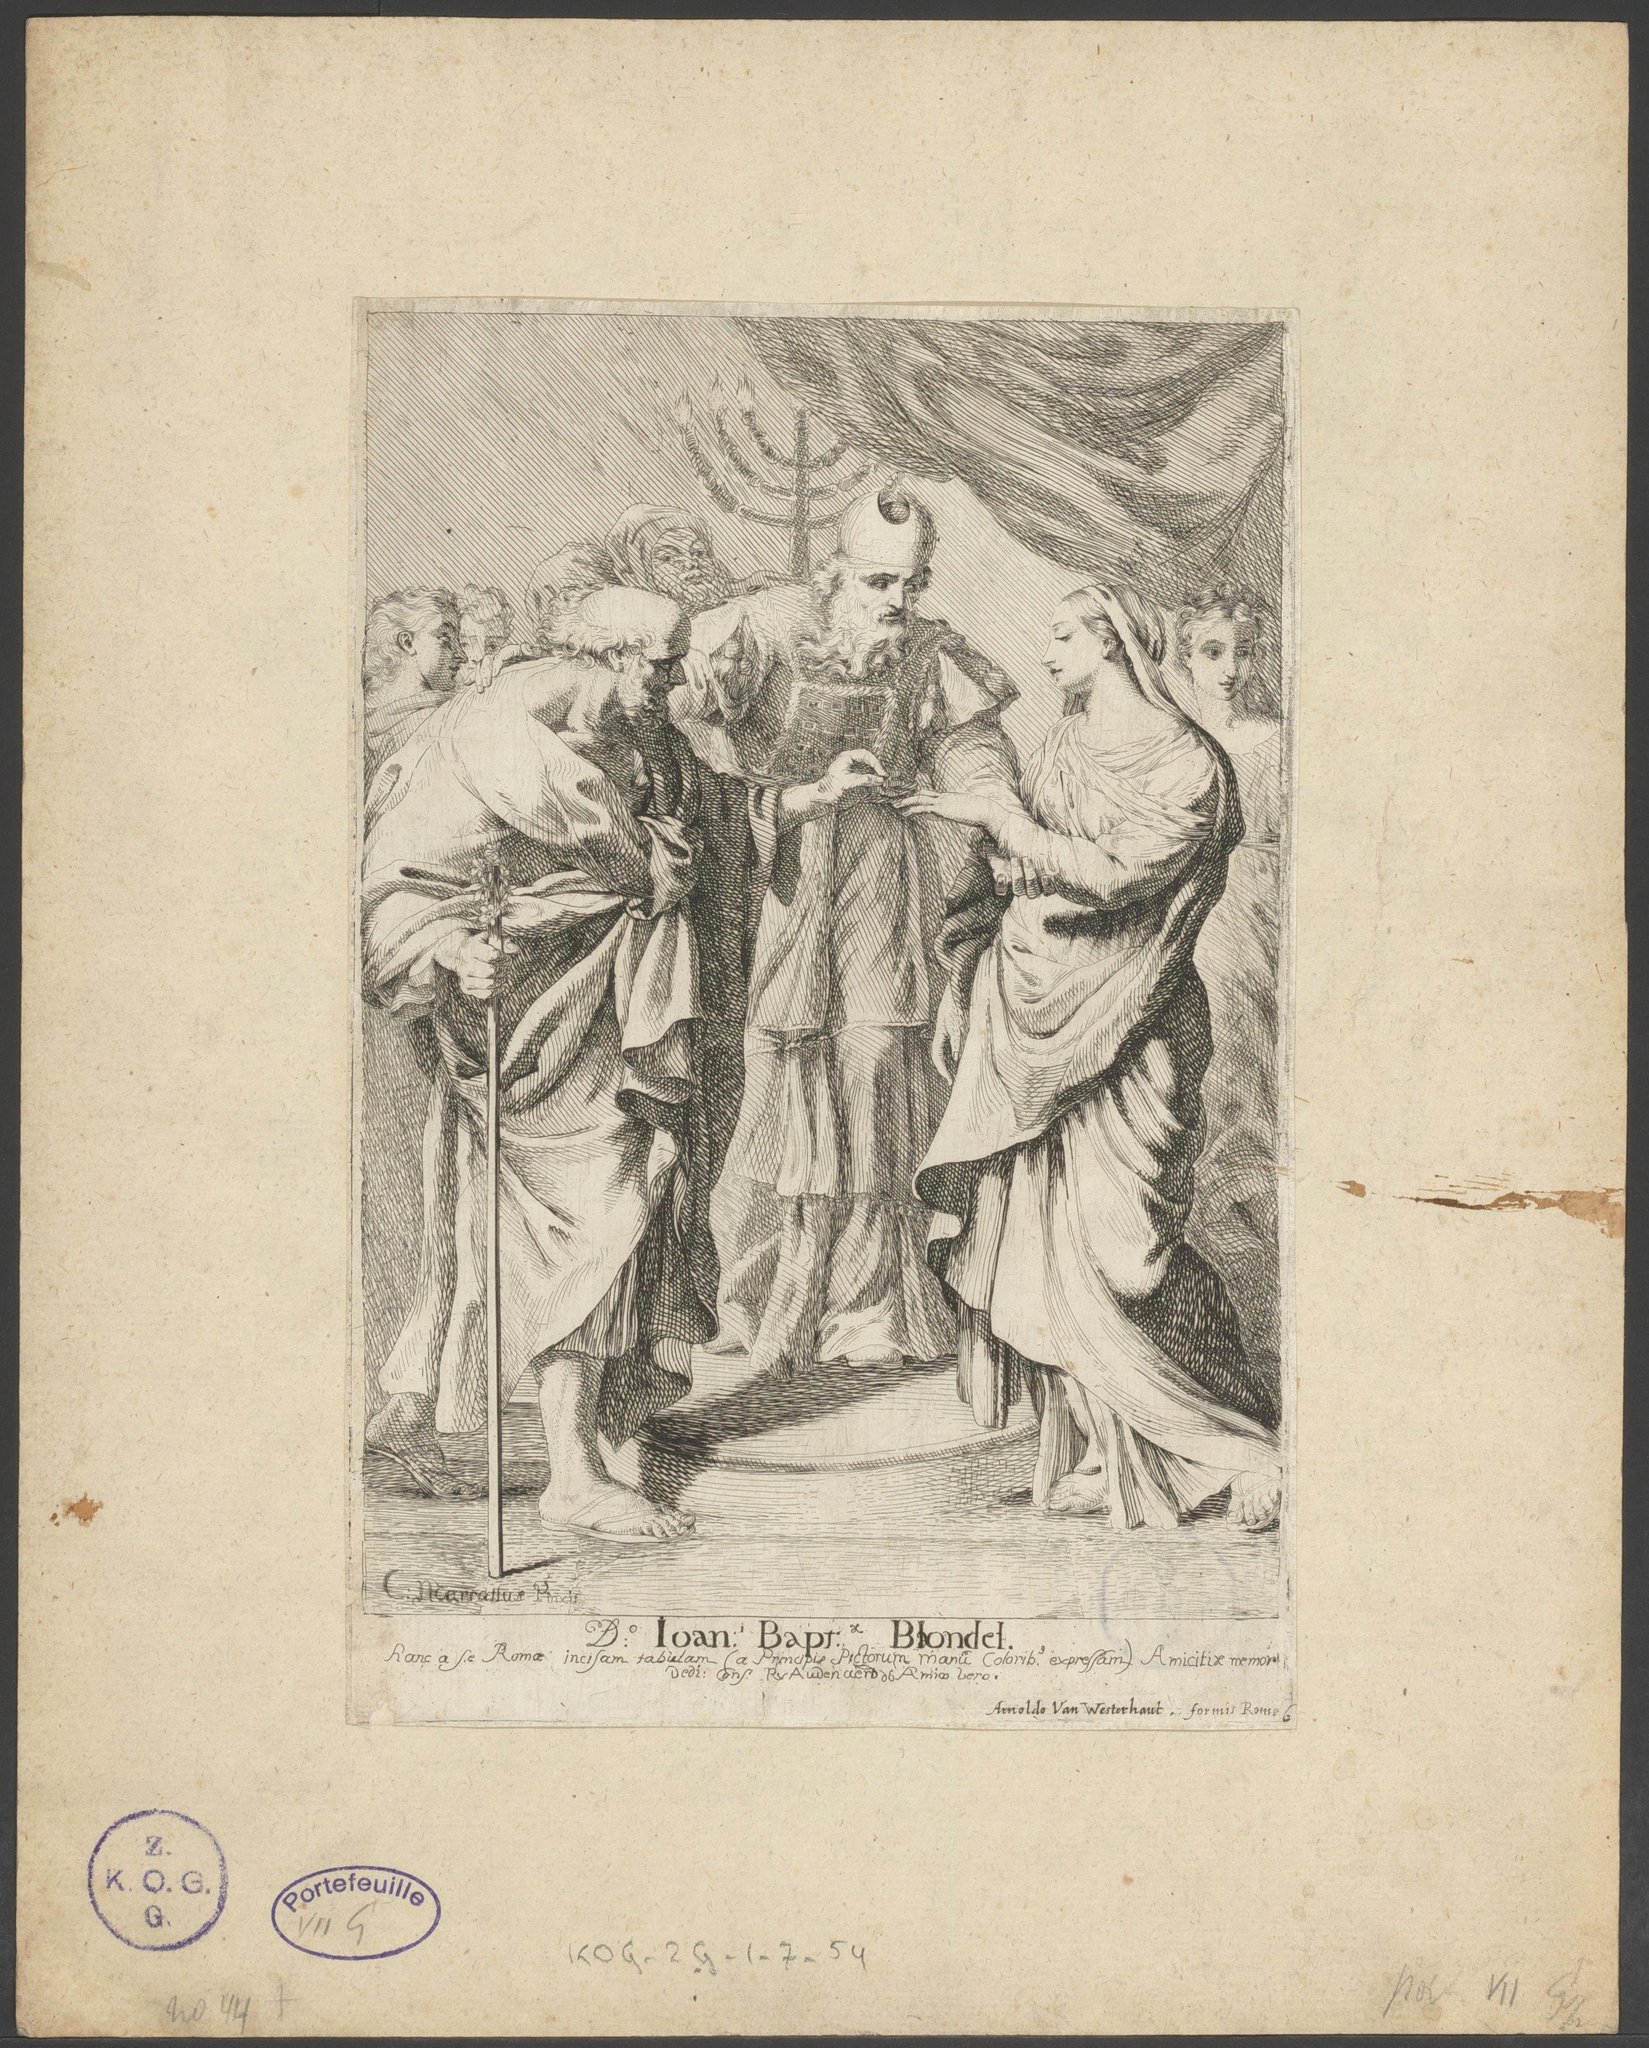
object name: print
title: D: Joan Bapt Blondel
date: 1661-1725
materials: paper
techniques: engraving, etching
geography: rome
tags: marriage of mary and joseph, 'sposalizio': they are married by the high priest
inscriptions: collector's mark: Lugt 1641, stamp, collector's mark: Lugt 1641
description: Jozef en Maria staan aan weerszijden van een priester in een tempel. Jozef schuift een ring om Maria's vinger. In zijn andere hand heeft hij de bloeiende staf, het teken dat hij de goede kandidaat voor Maria is. Plaat in het bezit van Arnold van Westerhout. Onderwerpsrubrieken binnen de Atlas Zeden en Gewoonten: Godsdienst, Roomsch-Katholieken, Processies, Herinneringen.